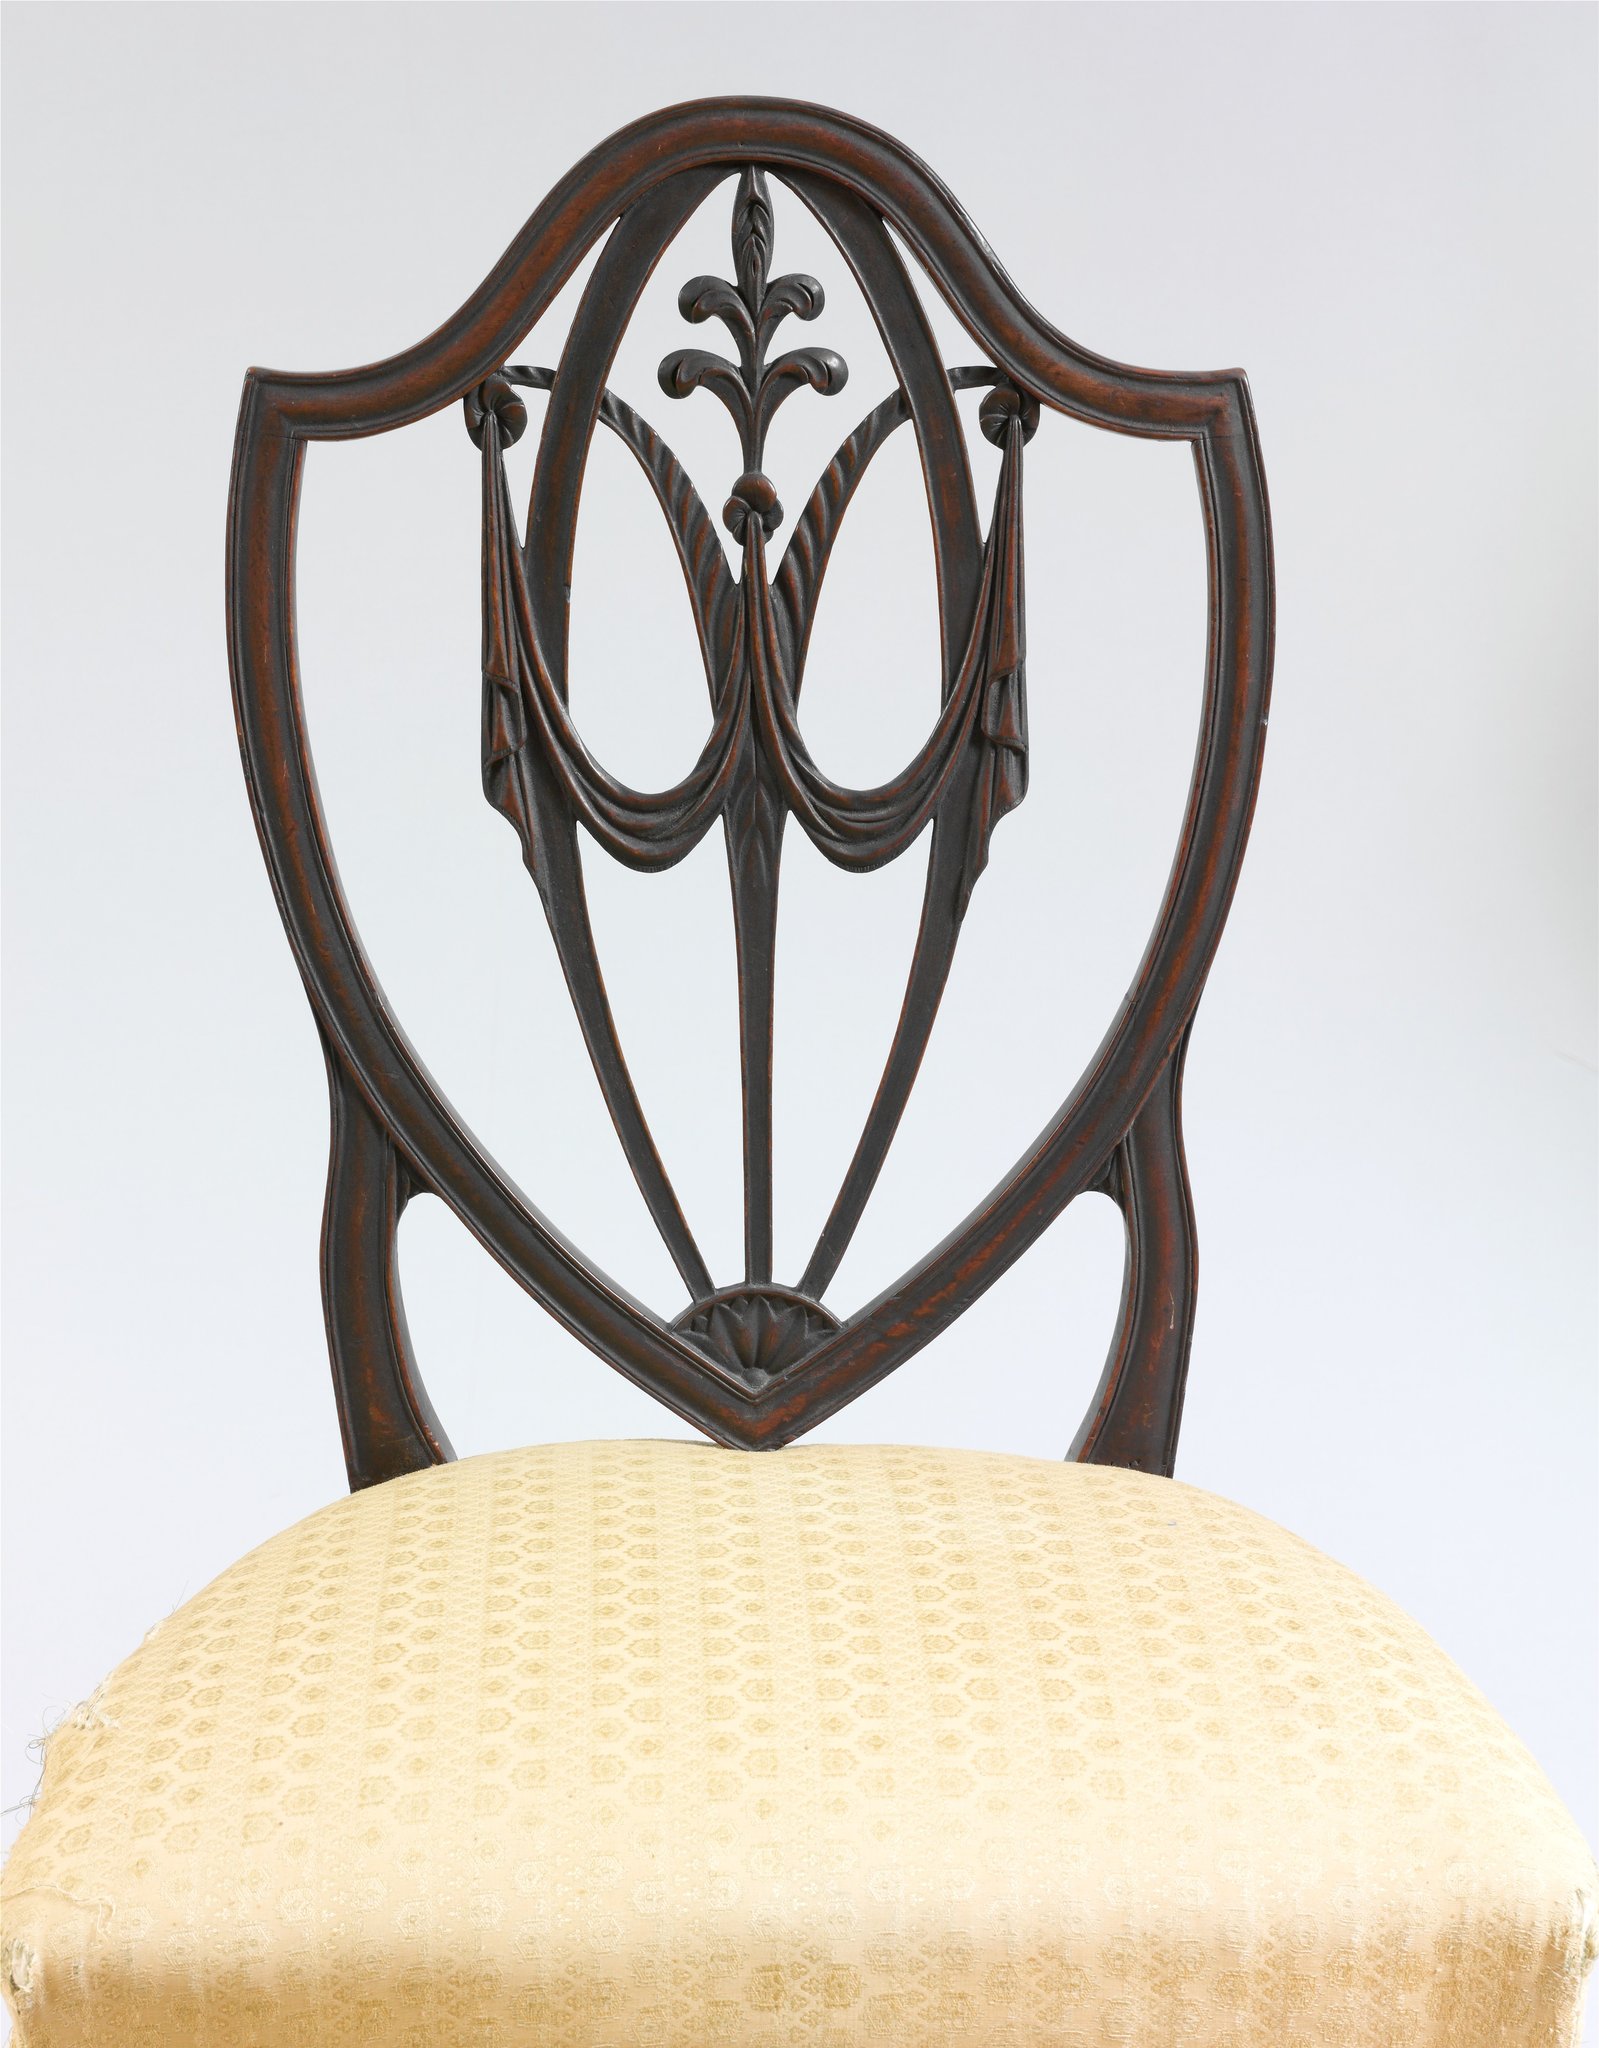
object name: side chair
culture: american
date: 1770-1800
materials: wood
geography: united states